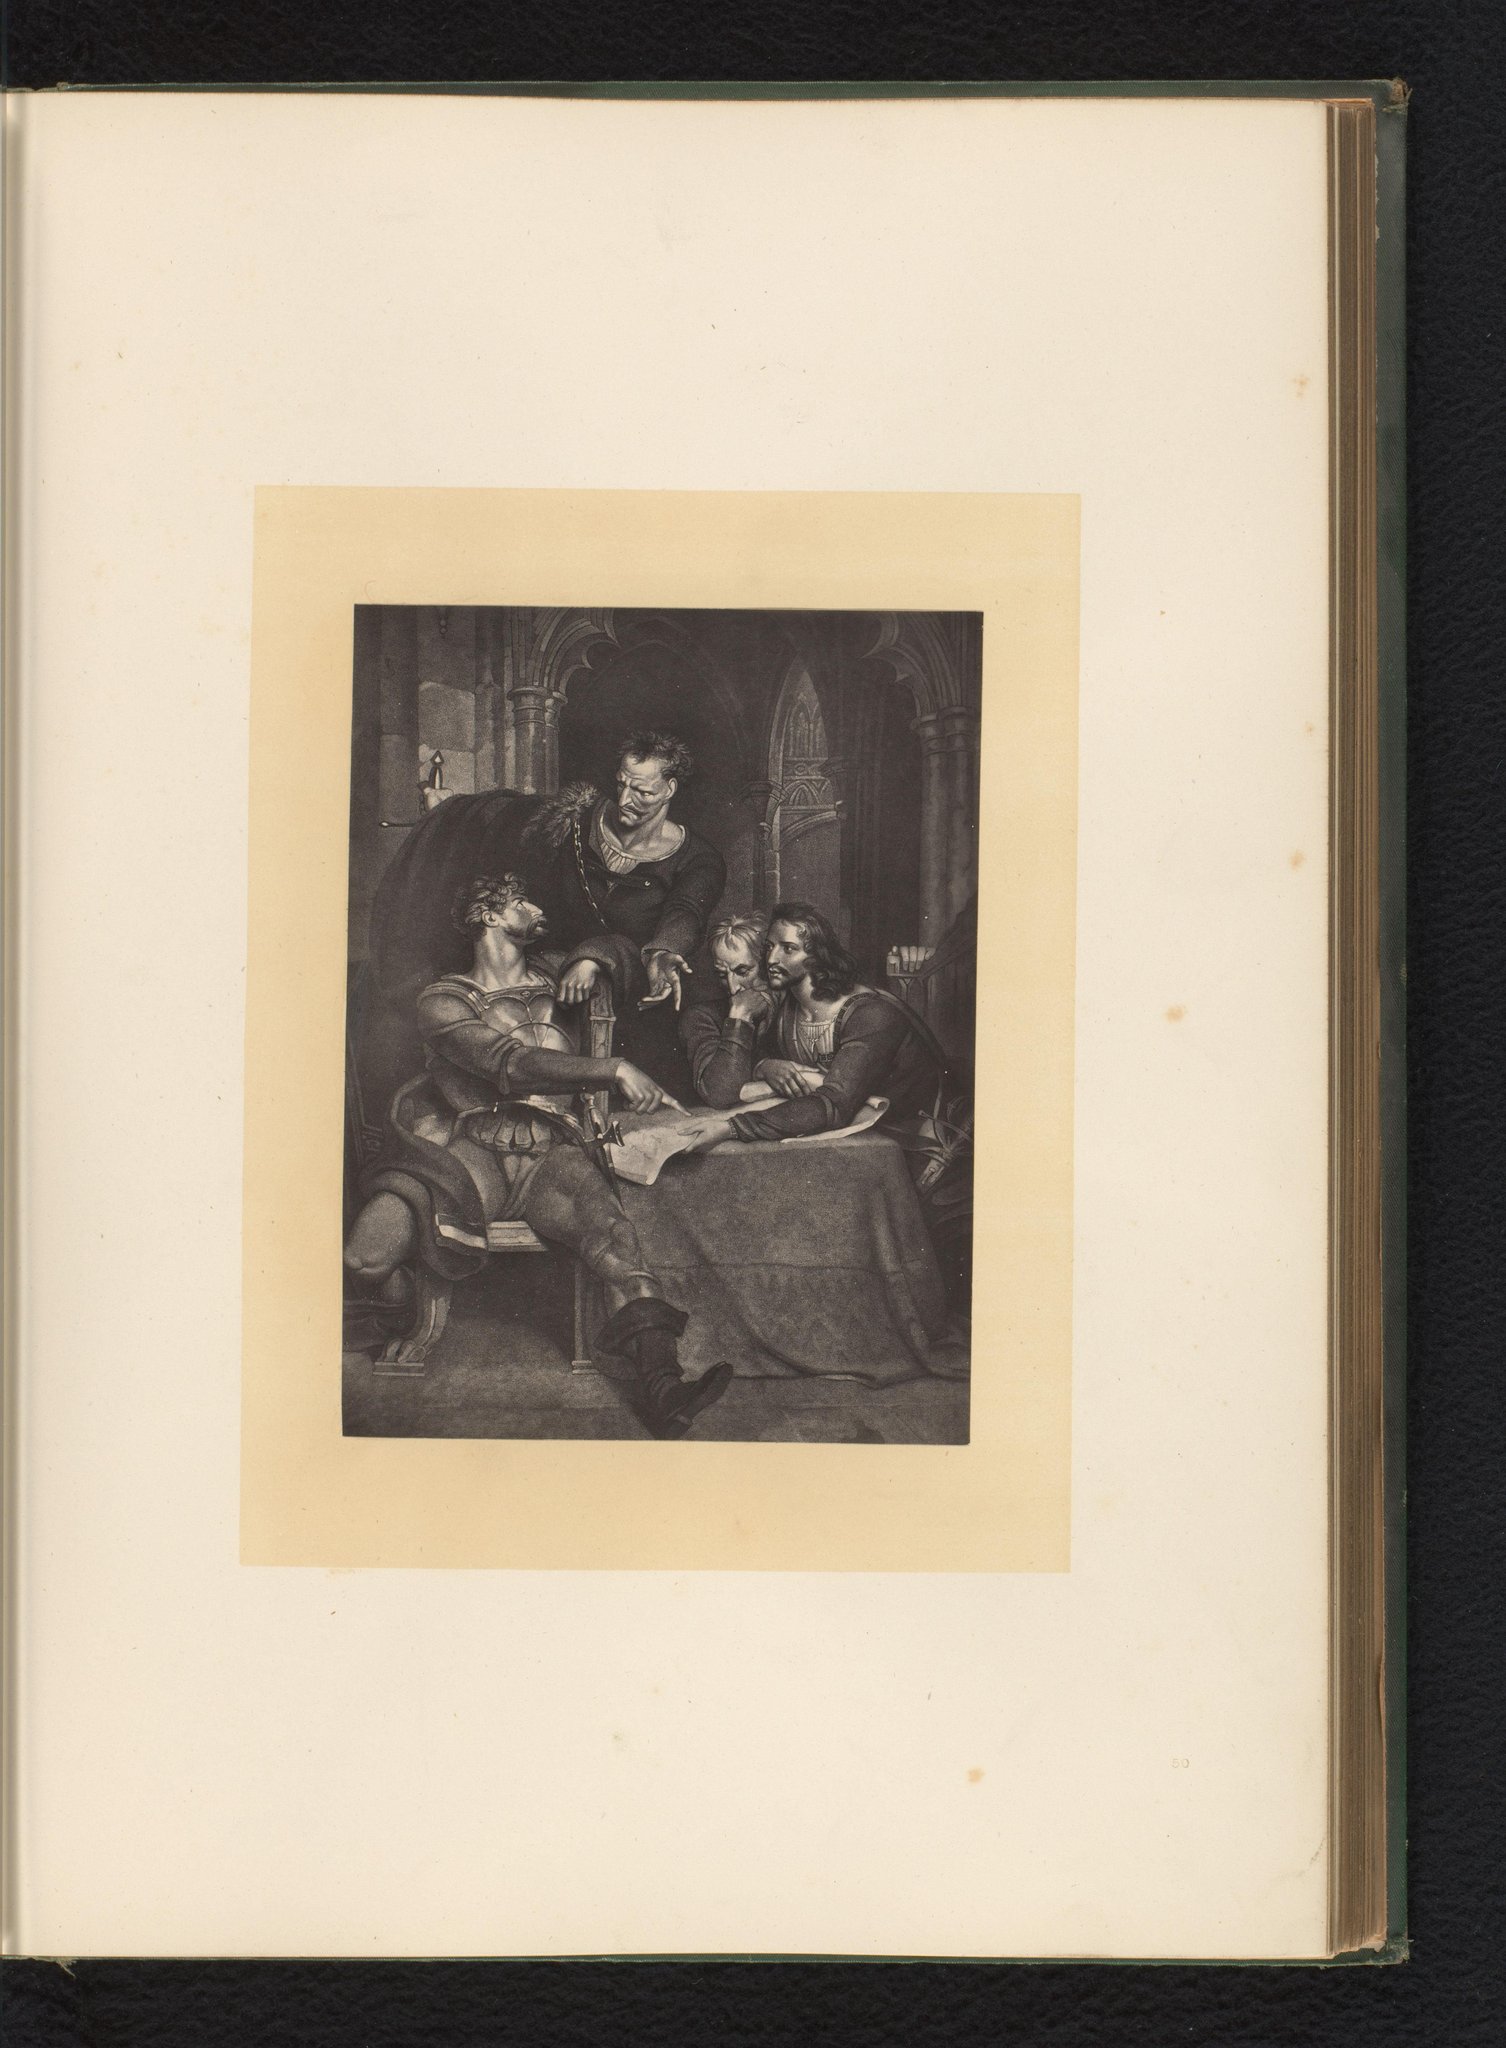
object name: reproduction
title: Reproductie van een gravure naar een schilderij van een scène uit King Henry the Fourth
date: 1874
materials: paper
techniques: woodburytype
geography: london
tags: theatre, theatrical performance